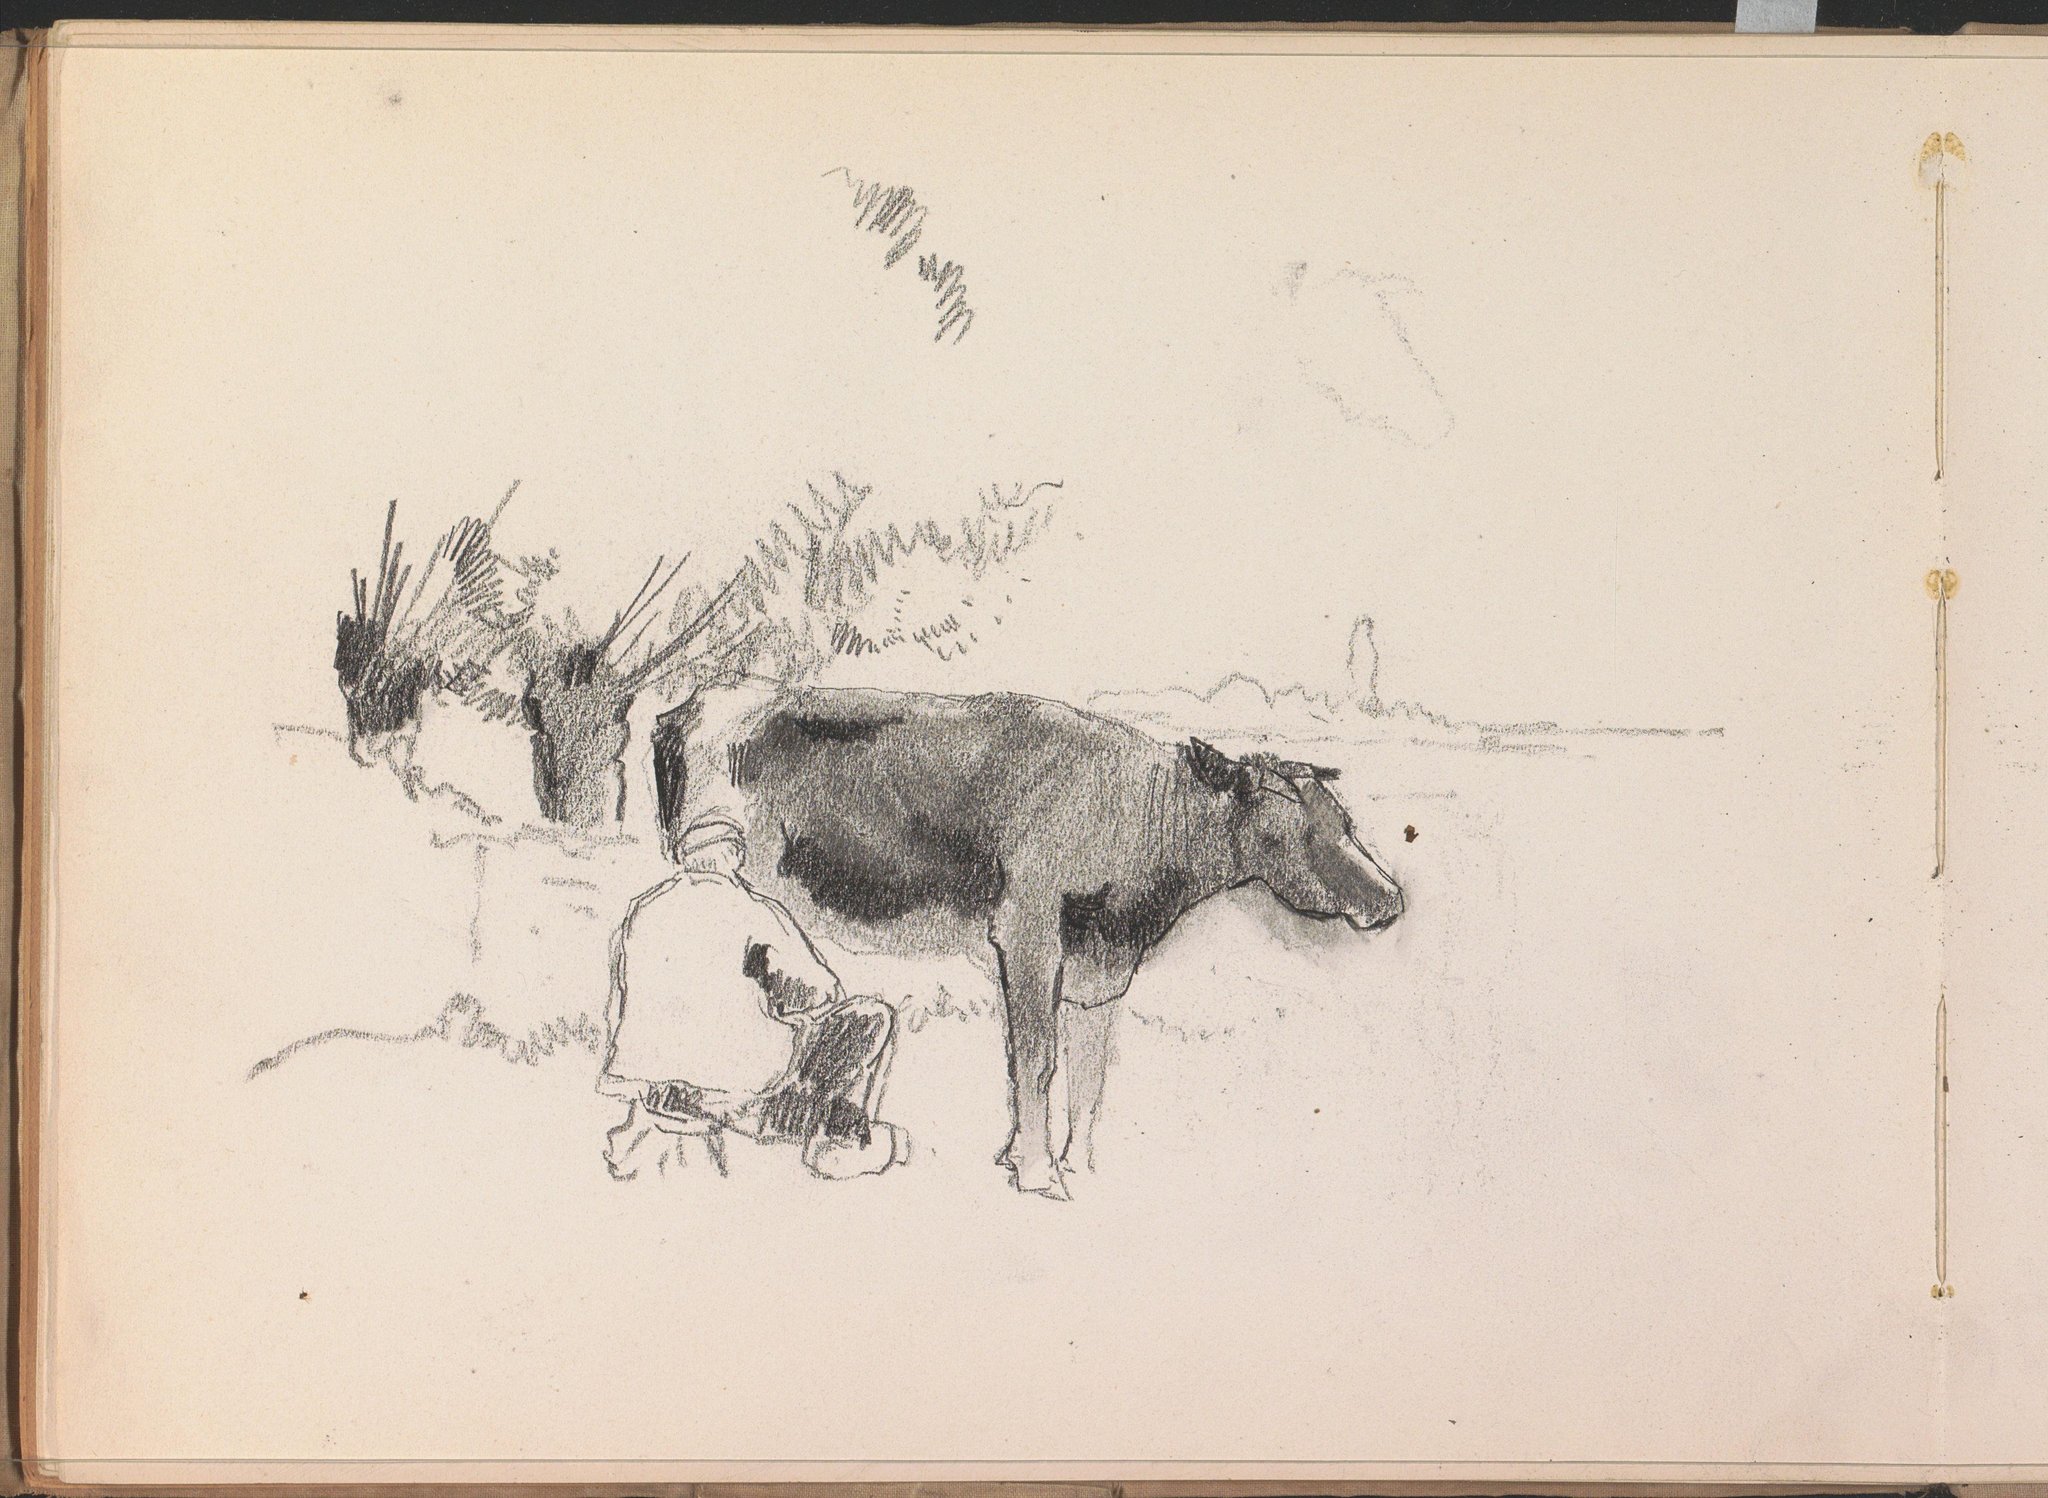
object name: sketchbook leaf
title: Boer die een koe melkt in een weiland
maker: cornelis vreedenburgh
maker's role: draughtsman, print maker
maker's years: 1880-1946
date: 1890-1946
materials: chalk, paper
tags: cow, meadow, pasture, milking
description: Pagina 19 verso uit een schetsboek met 22 bladen.